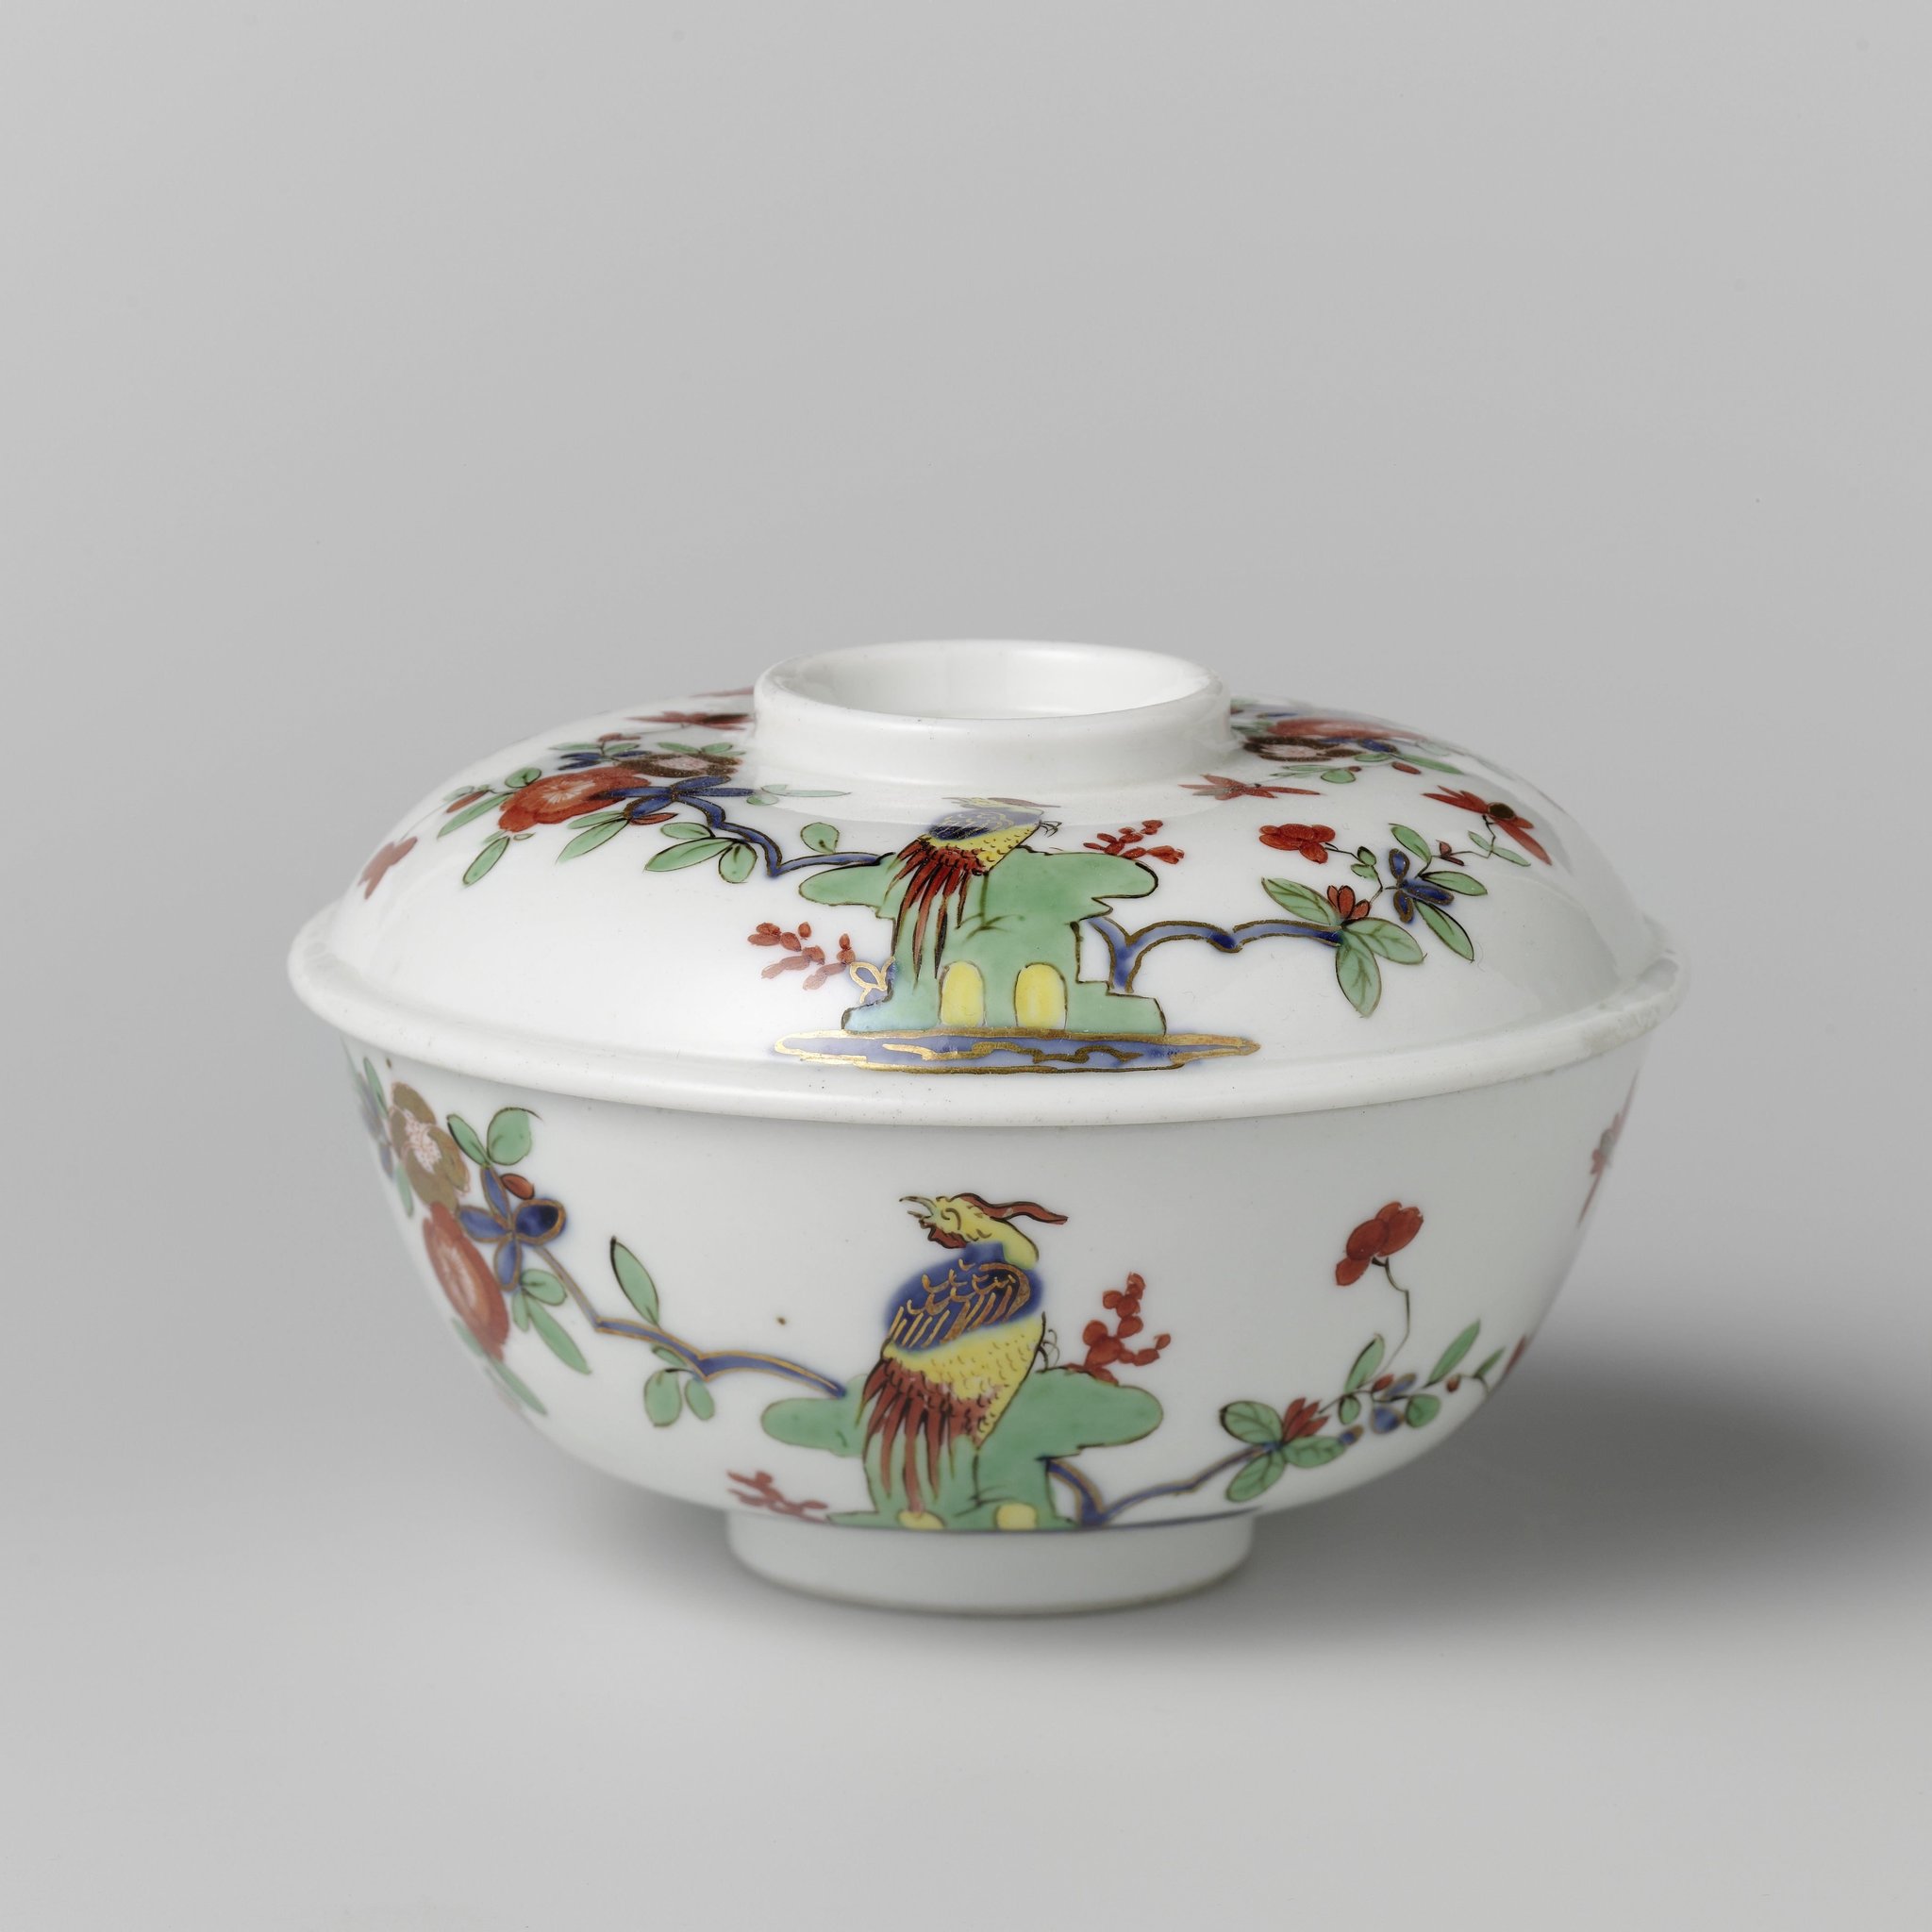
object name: bowl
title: Deksel, veelkleurig beschilderd met een Kakiemon-decor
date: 1725-1730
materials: porcelain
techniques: painted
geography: meissen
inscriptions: factory mark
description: Een gewelfd deksel met in het midden een opstaande ring. De beschildering bestaat uit een vogel op een rots, waarachter aan weerszijden een tak met bloemen groeit. Deze voorstelling komt twee maal zowel op de kom als op het deksel voor.